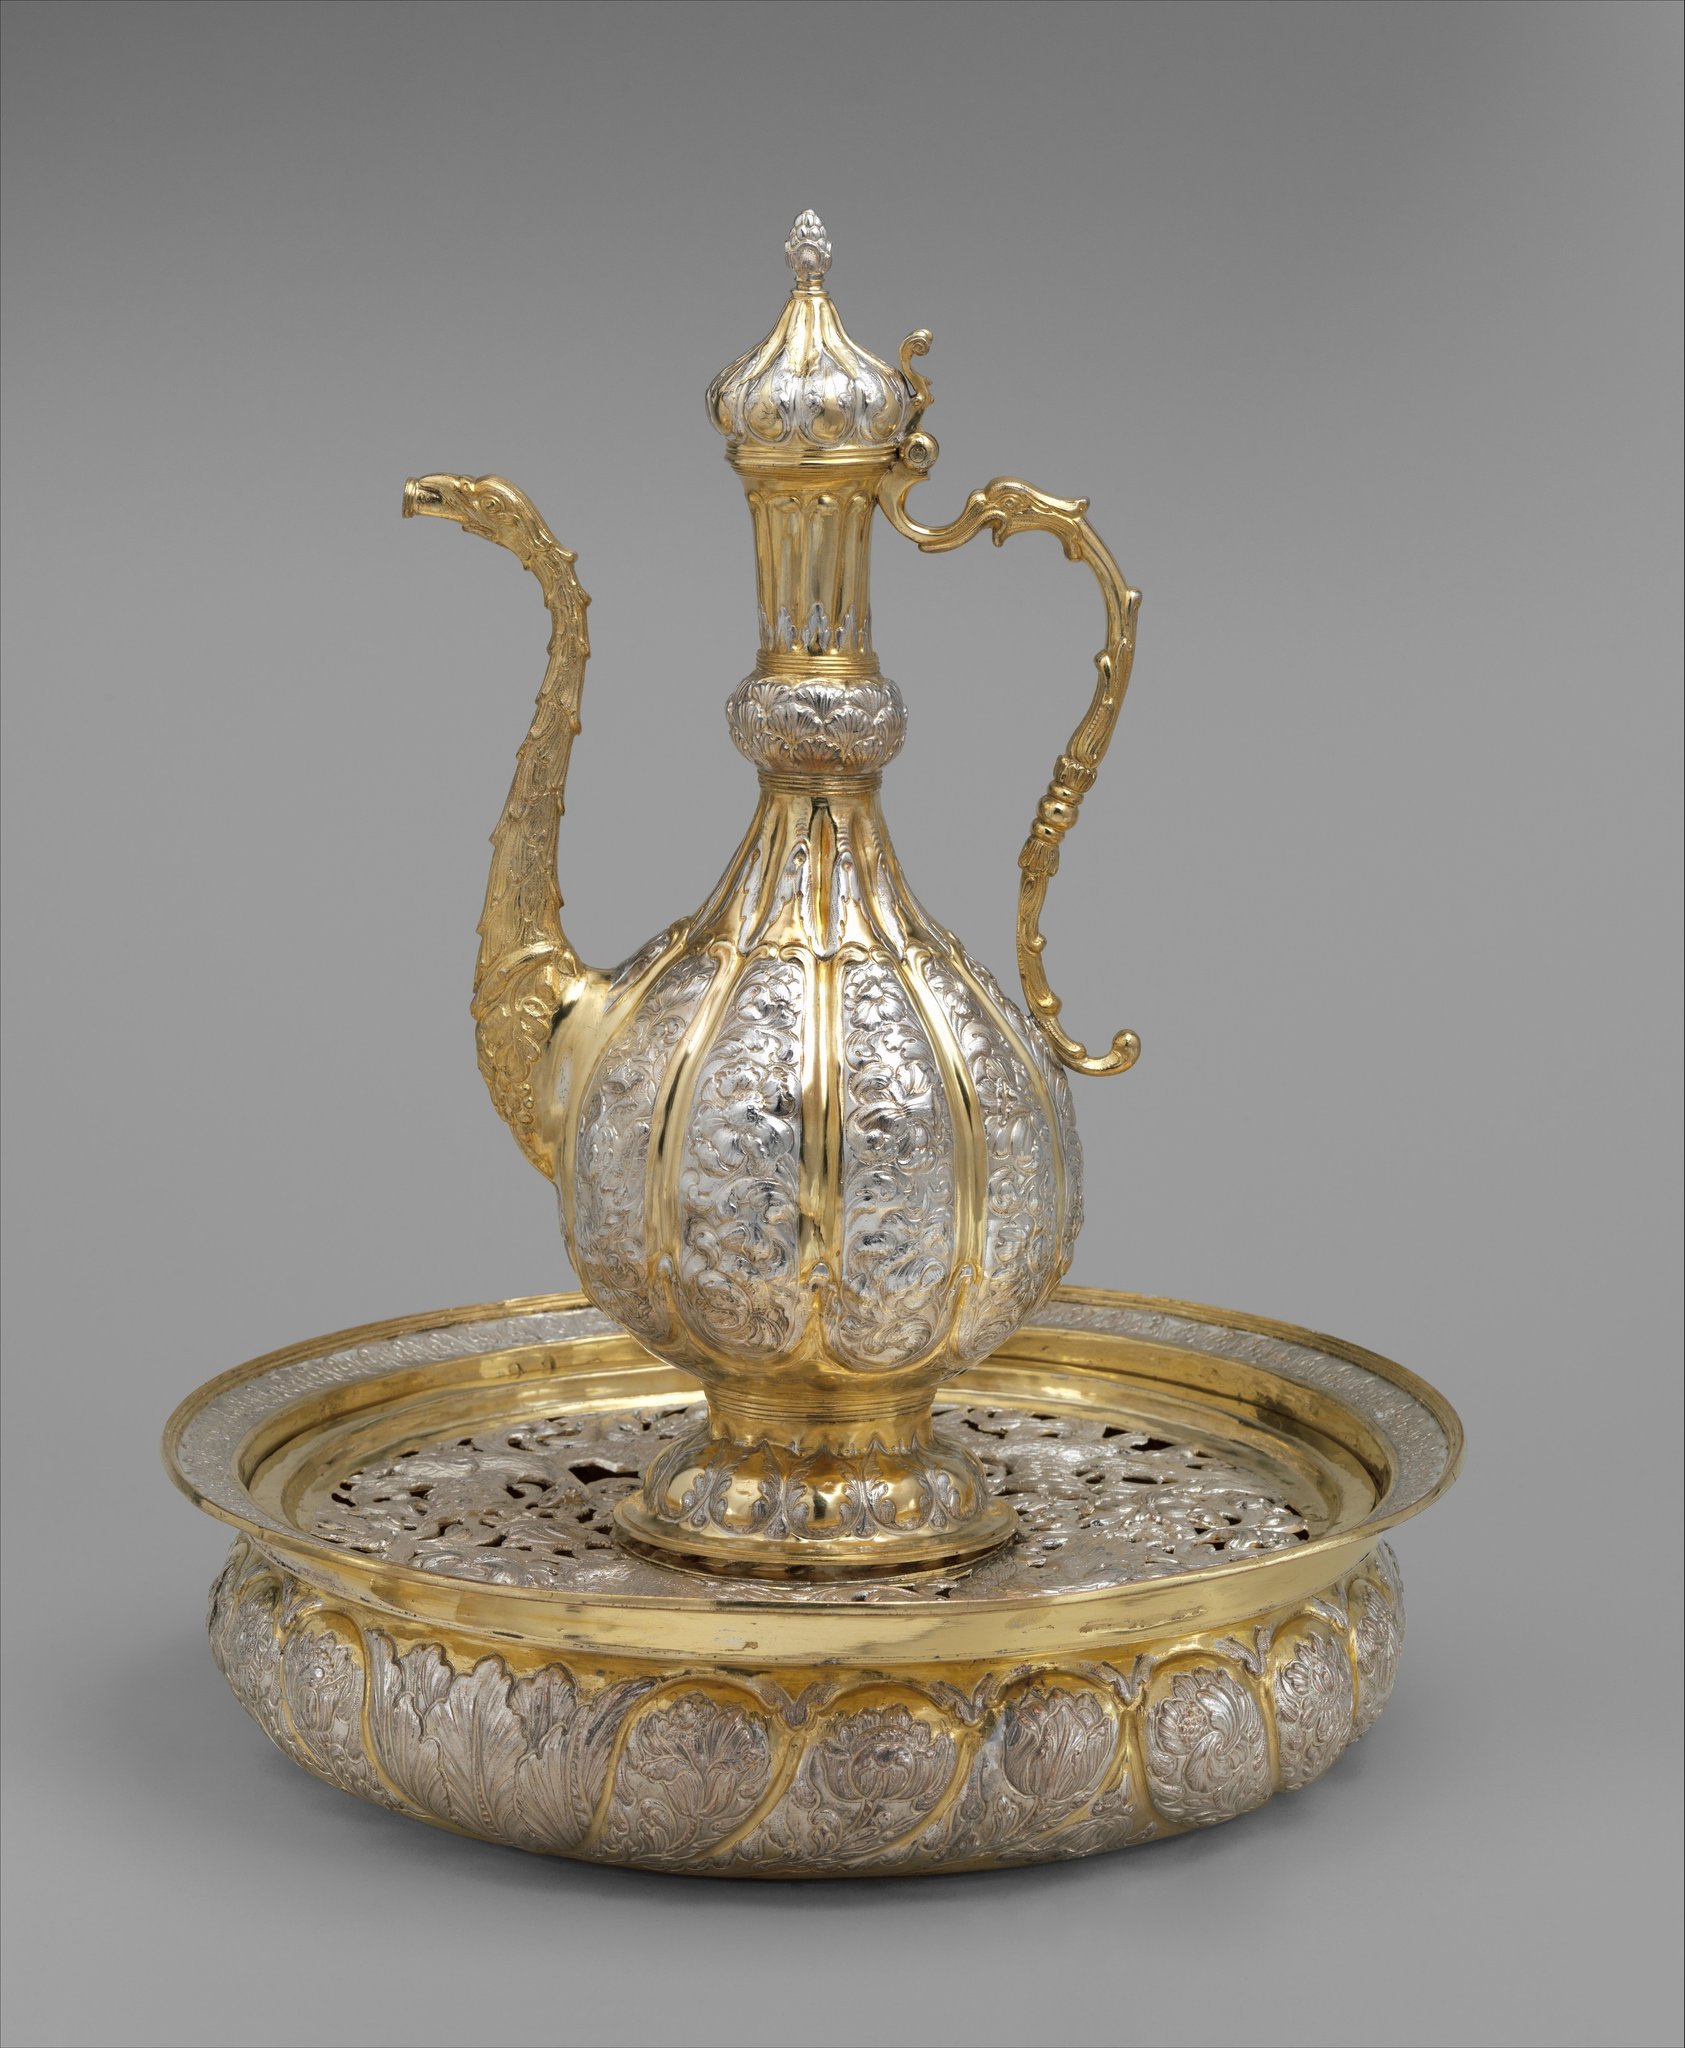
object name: basin with tray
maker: elkington & co.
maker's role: manufacturer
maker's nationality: british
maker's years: 1829-1963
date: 1801-1900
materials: gilt, metal, silver